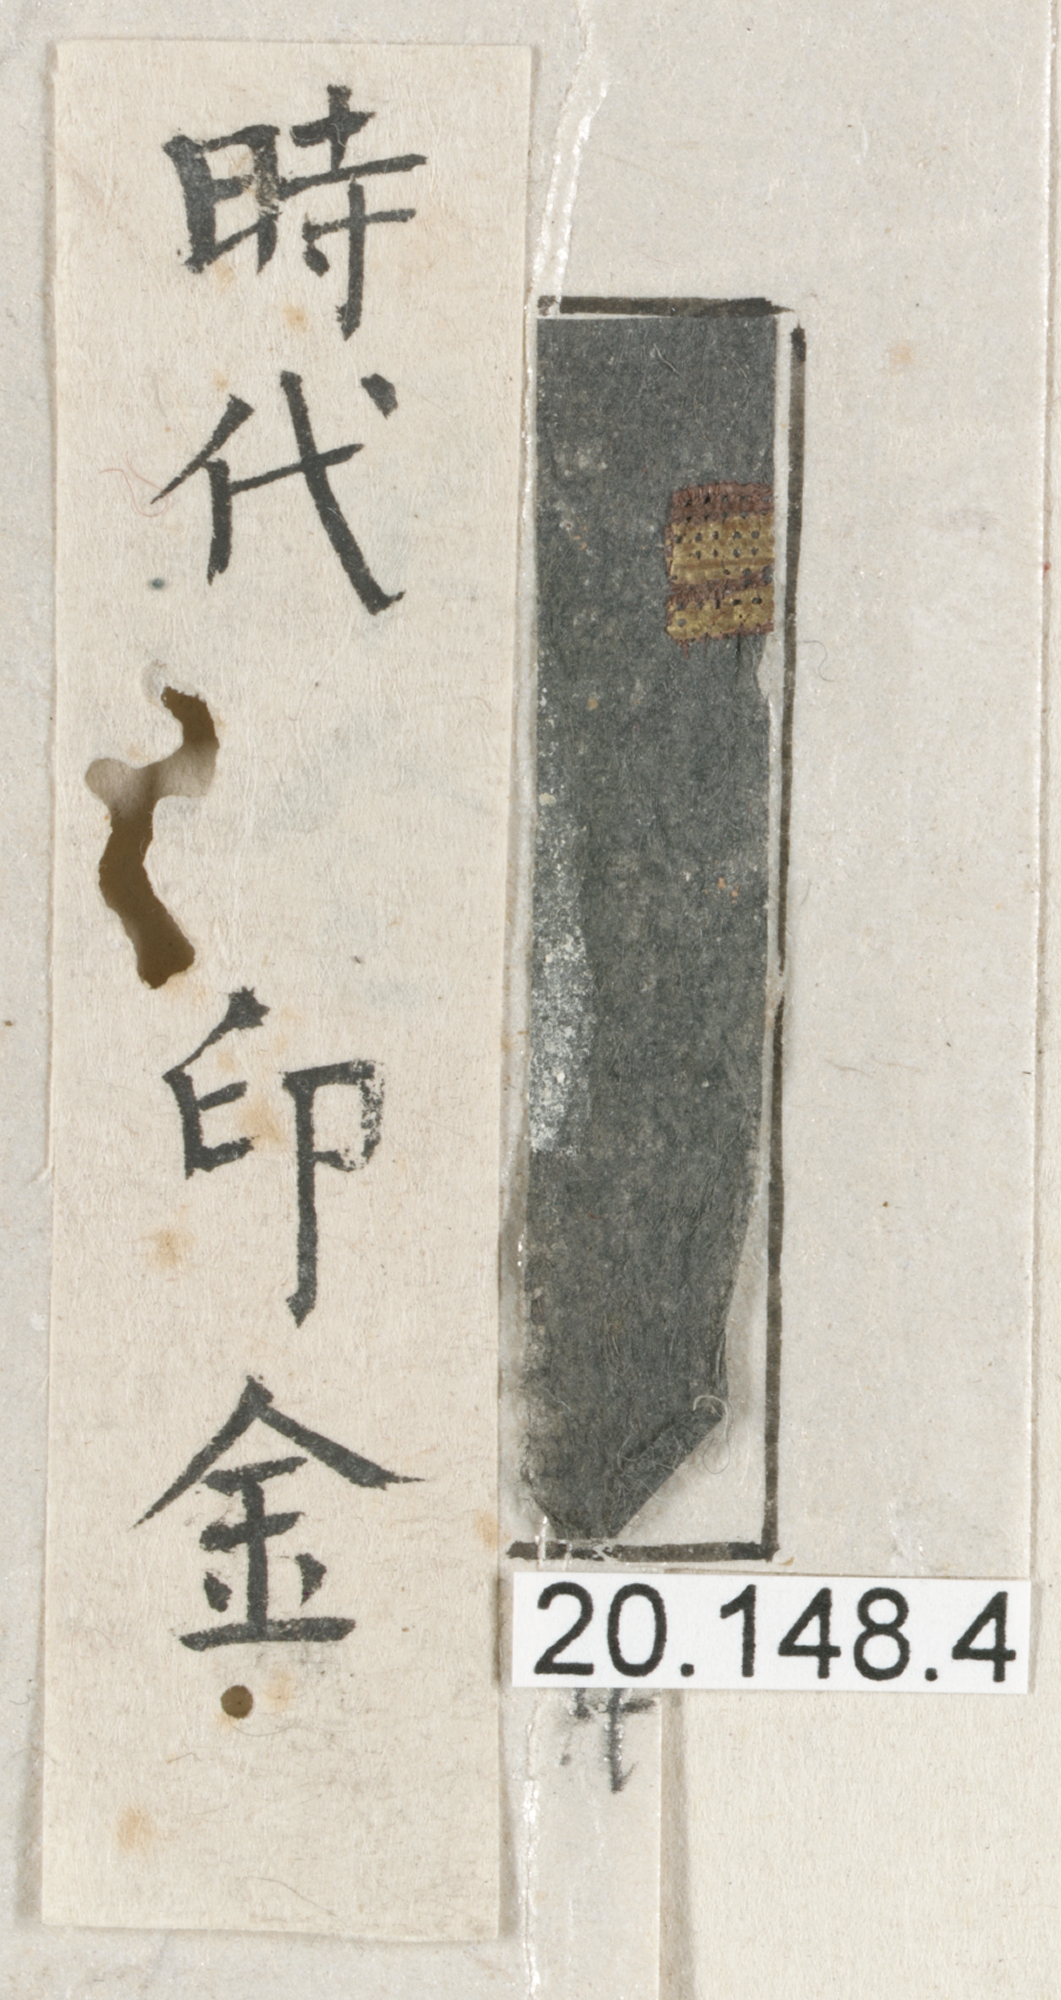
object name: piece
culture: japanese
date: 901-1000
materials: silk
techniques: compound weave